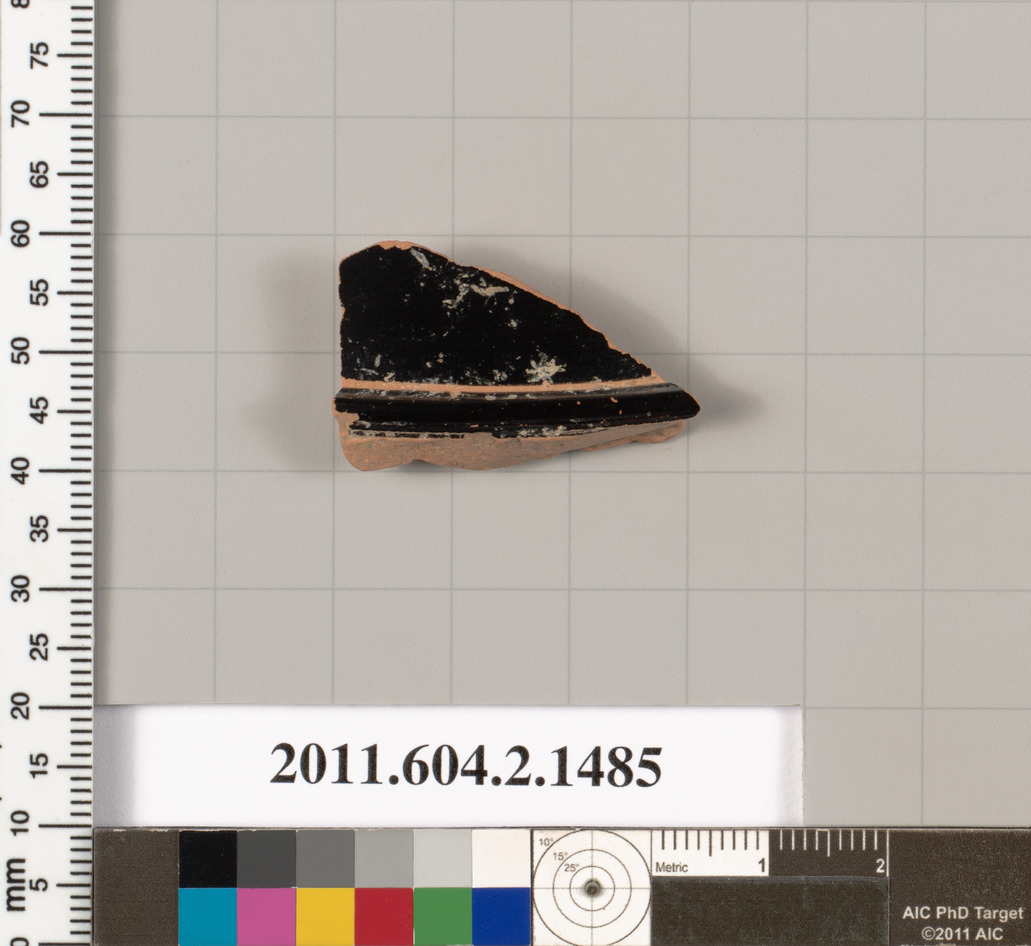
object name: skyphos fragment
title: Terracotta fragment of a skyphos (deep drinking cup)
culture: greek, attic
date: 600-401 BCE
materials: terracotta